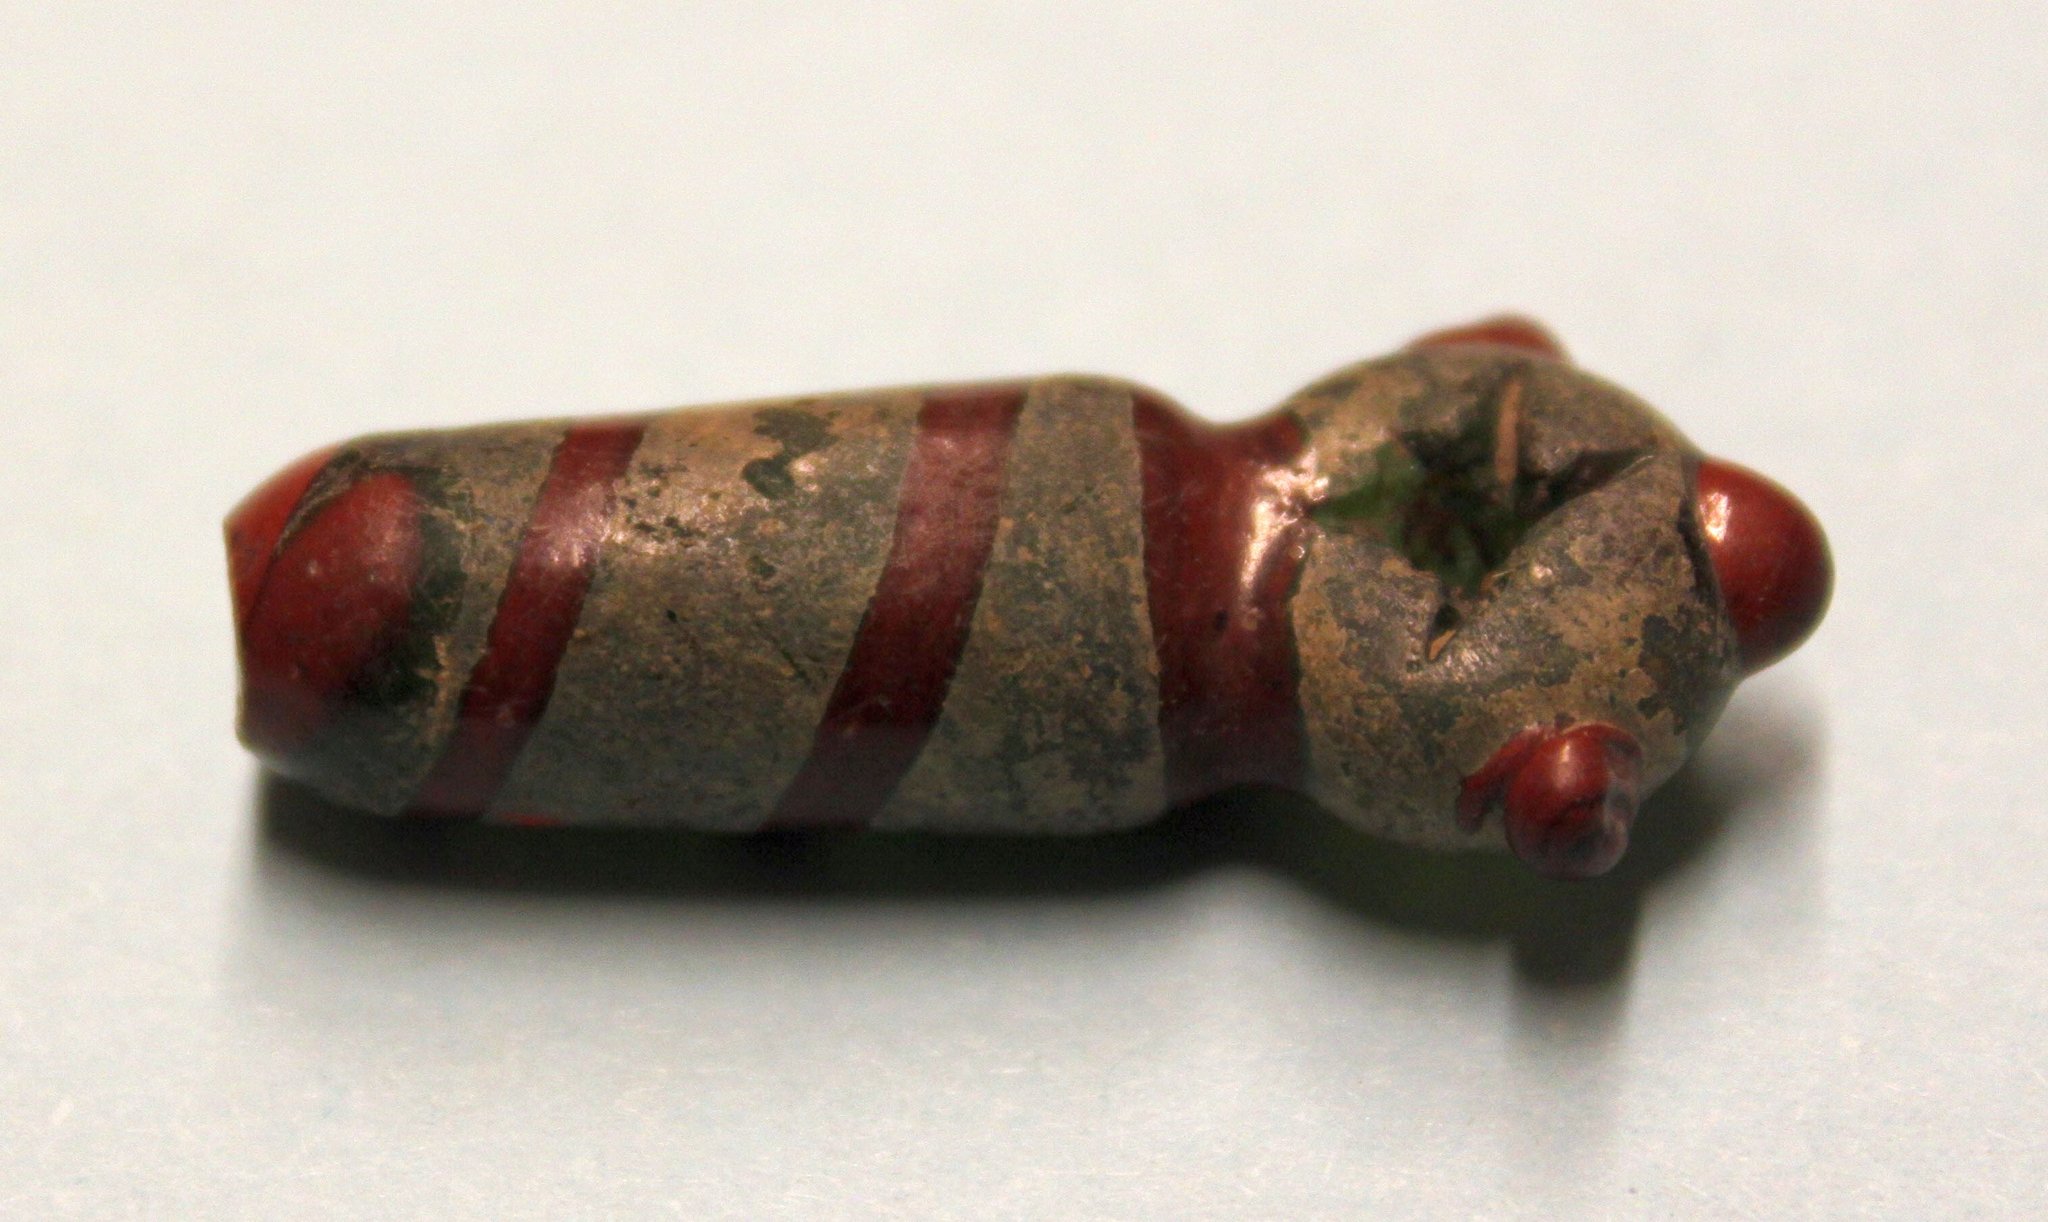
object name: pendant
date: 801-1900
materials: glass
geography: egypt